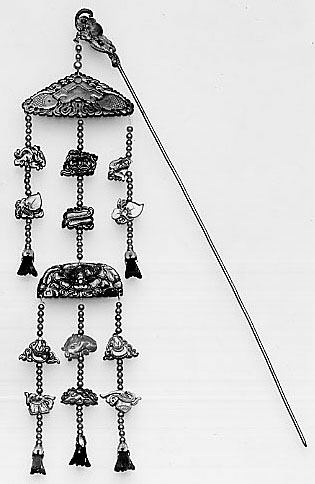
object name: hairpin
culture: chinese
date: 1701-1800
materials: amber, feather, metal, pearl